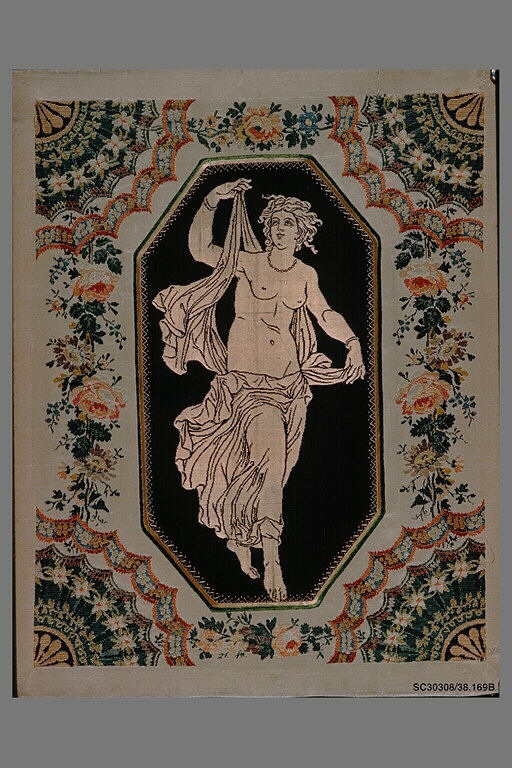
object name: upholstery panel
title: Part of a chair cover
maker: jean démosthène dugourc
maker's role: designer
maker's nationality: french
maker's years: 1749-1825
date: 1797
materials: silk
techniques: brocade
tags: female nudes,flowers